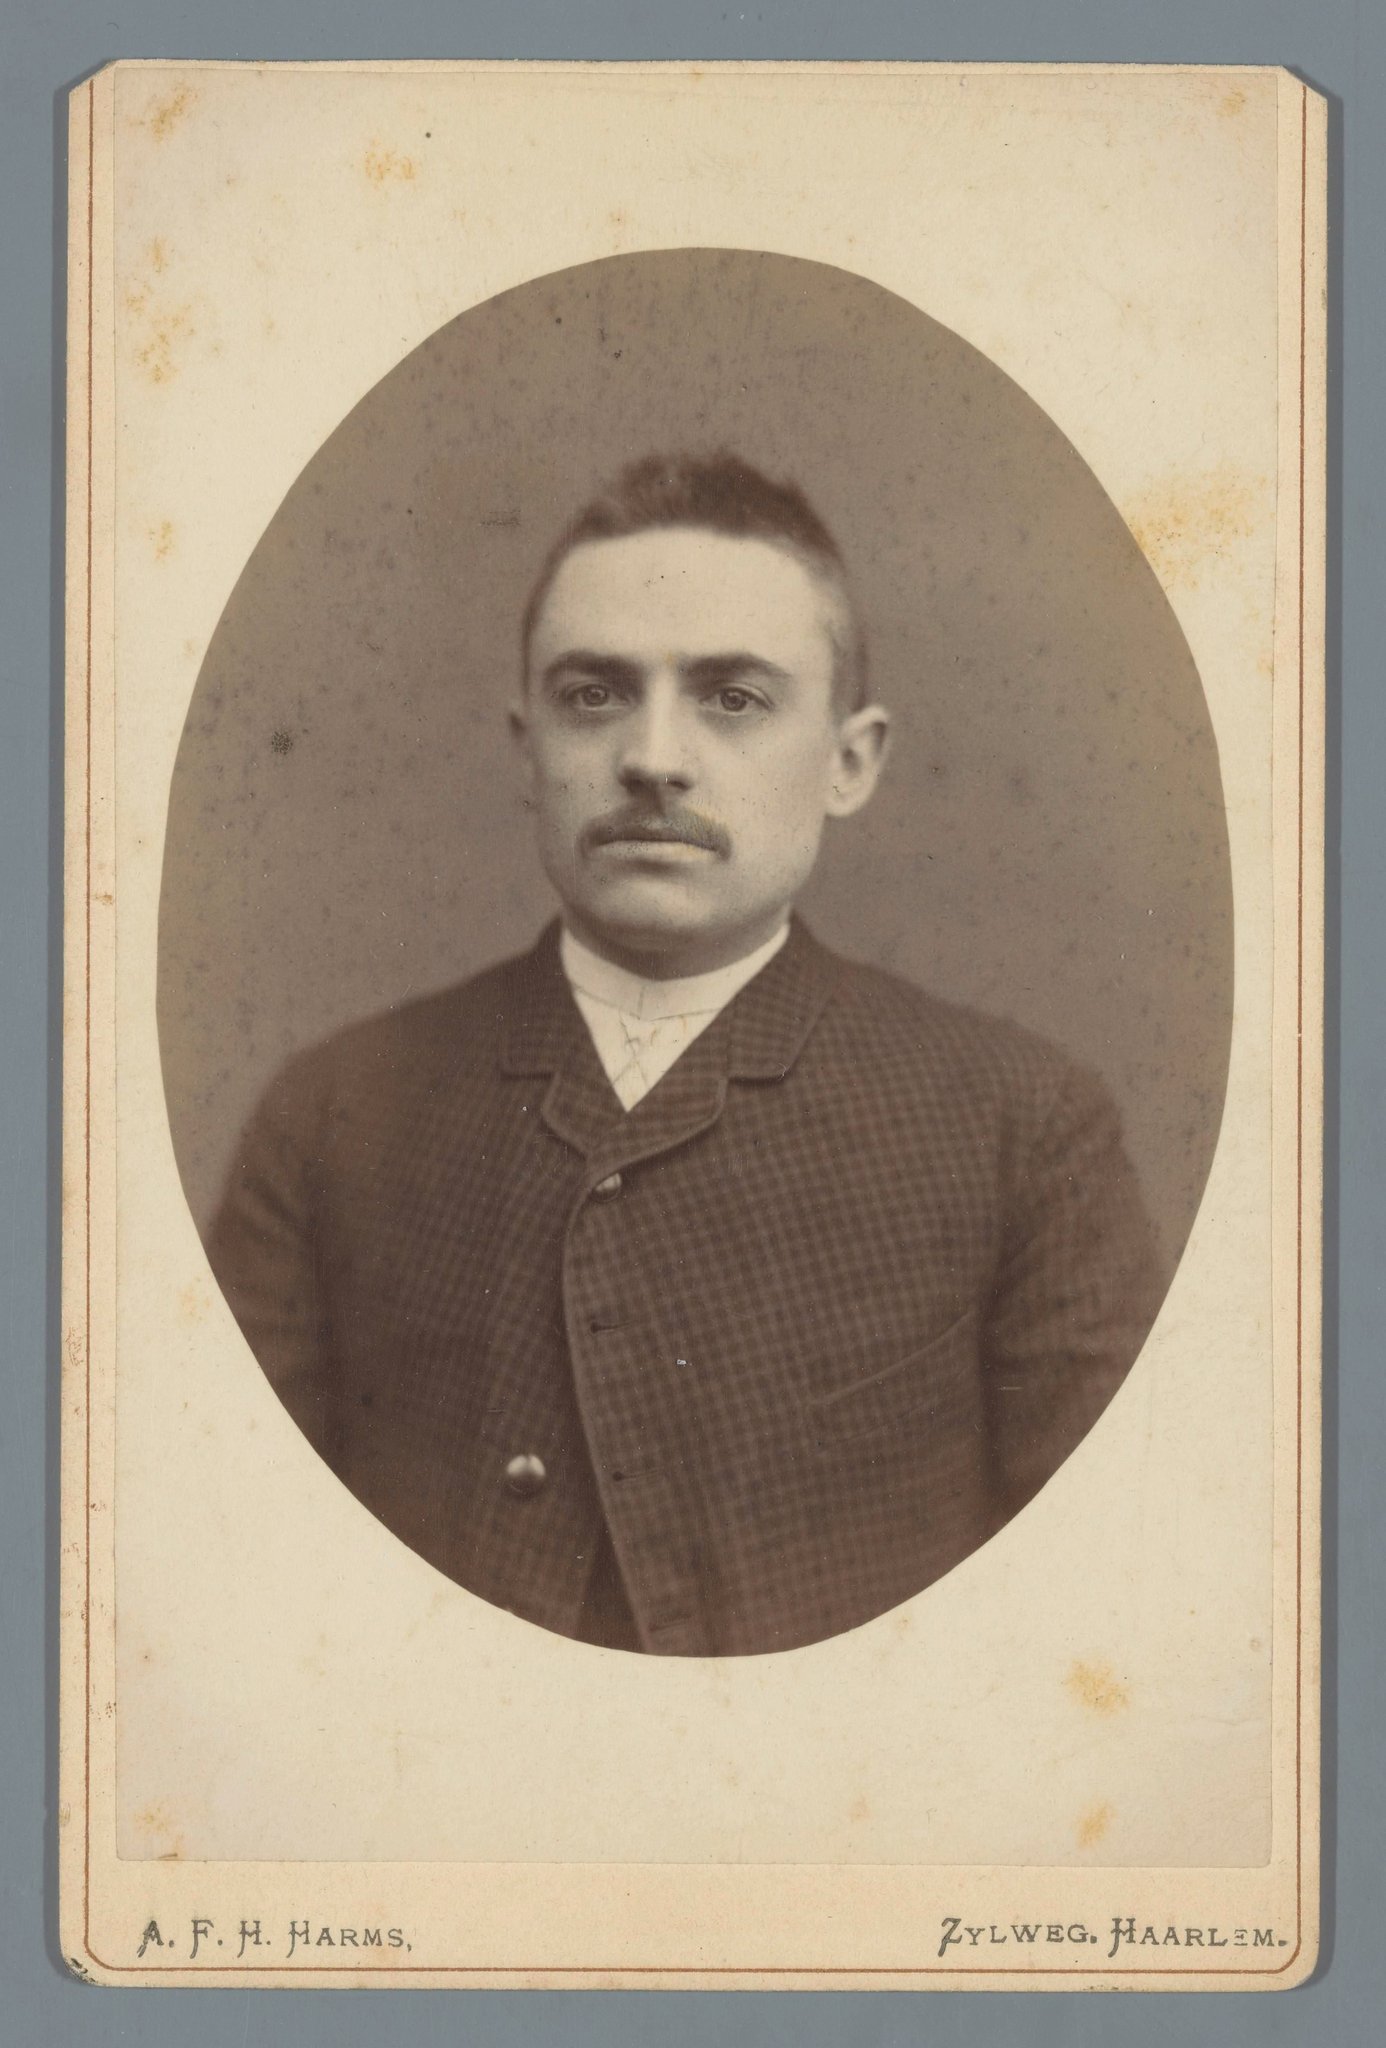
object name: cabinet photograph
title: Portret van J. de Weeger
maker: august ferdinand heinrich harms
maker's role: fotograaf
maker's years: 1845-1916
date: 1884-1900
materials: cardboard, photographic support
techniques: albumen print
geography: haarlem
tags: adult man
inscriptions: name: ‘A.F.H. Harms, Zylweg. Haarlem.’